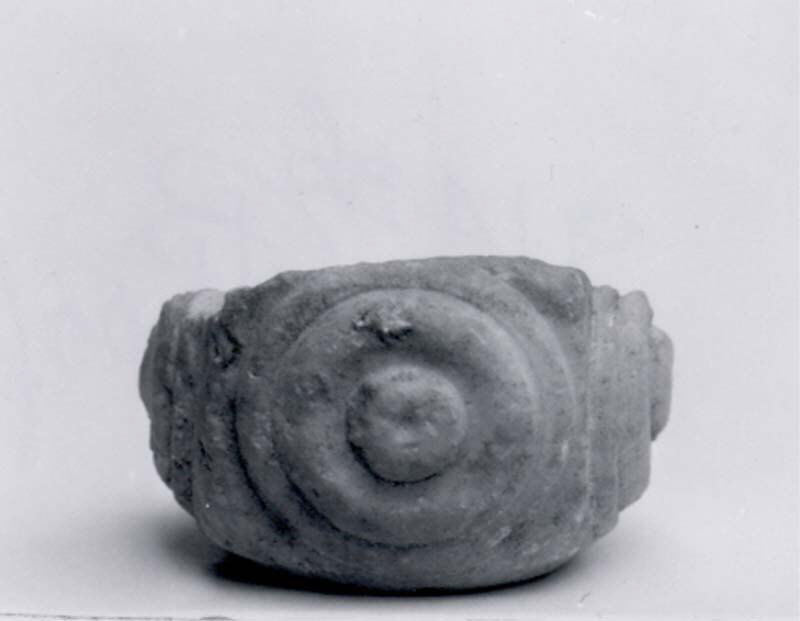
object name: dish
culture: sasanian or islamic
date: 501-800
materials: marble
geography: mesopotamia